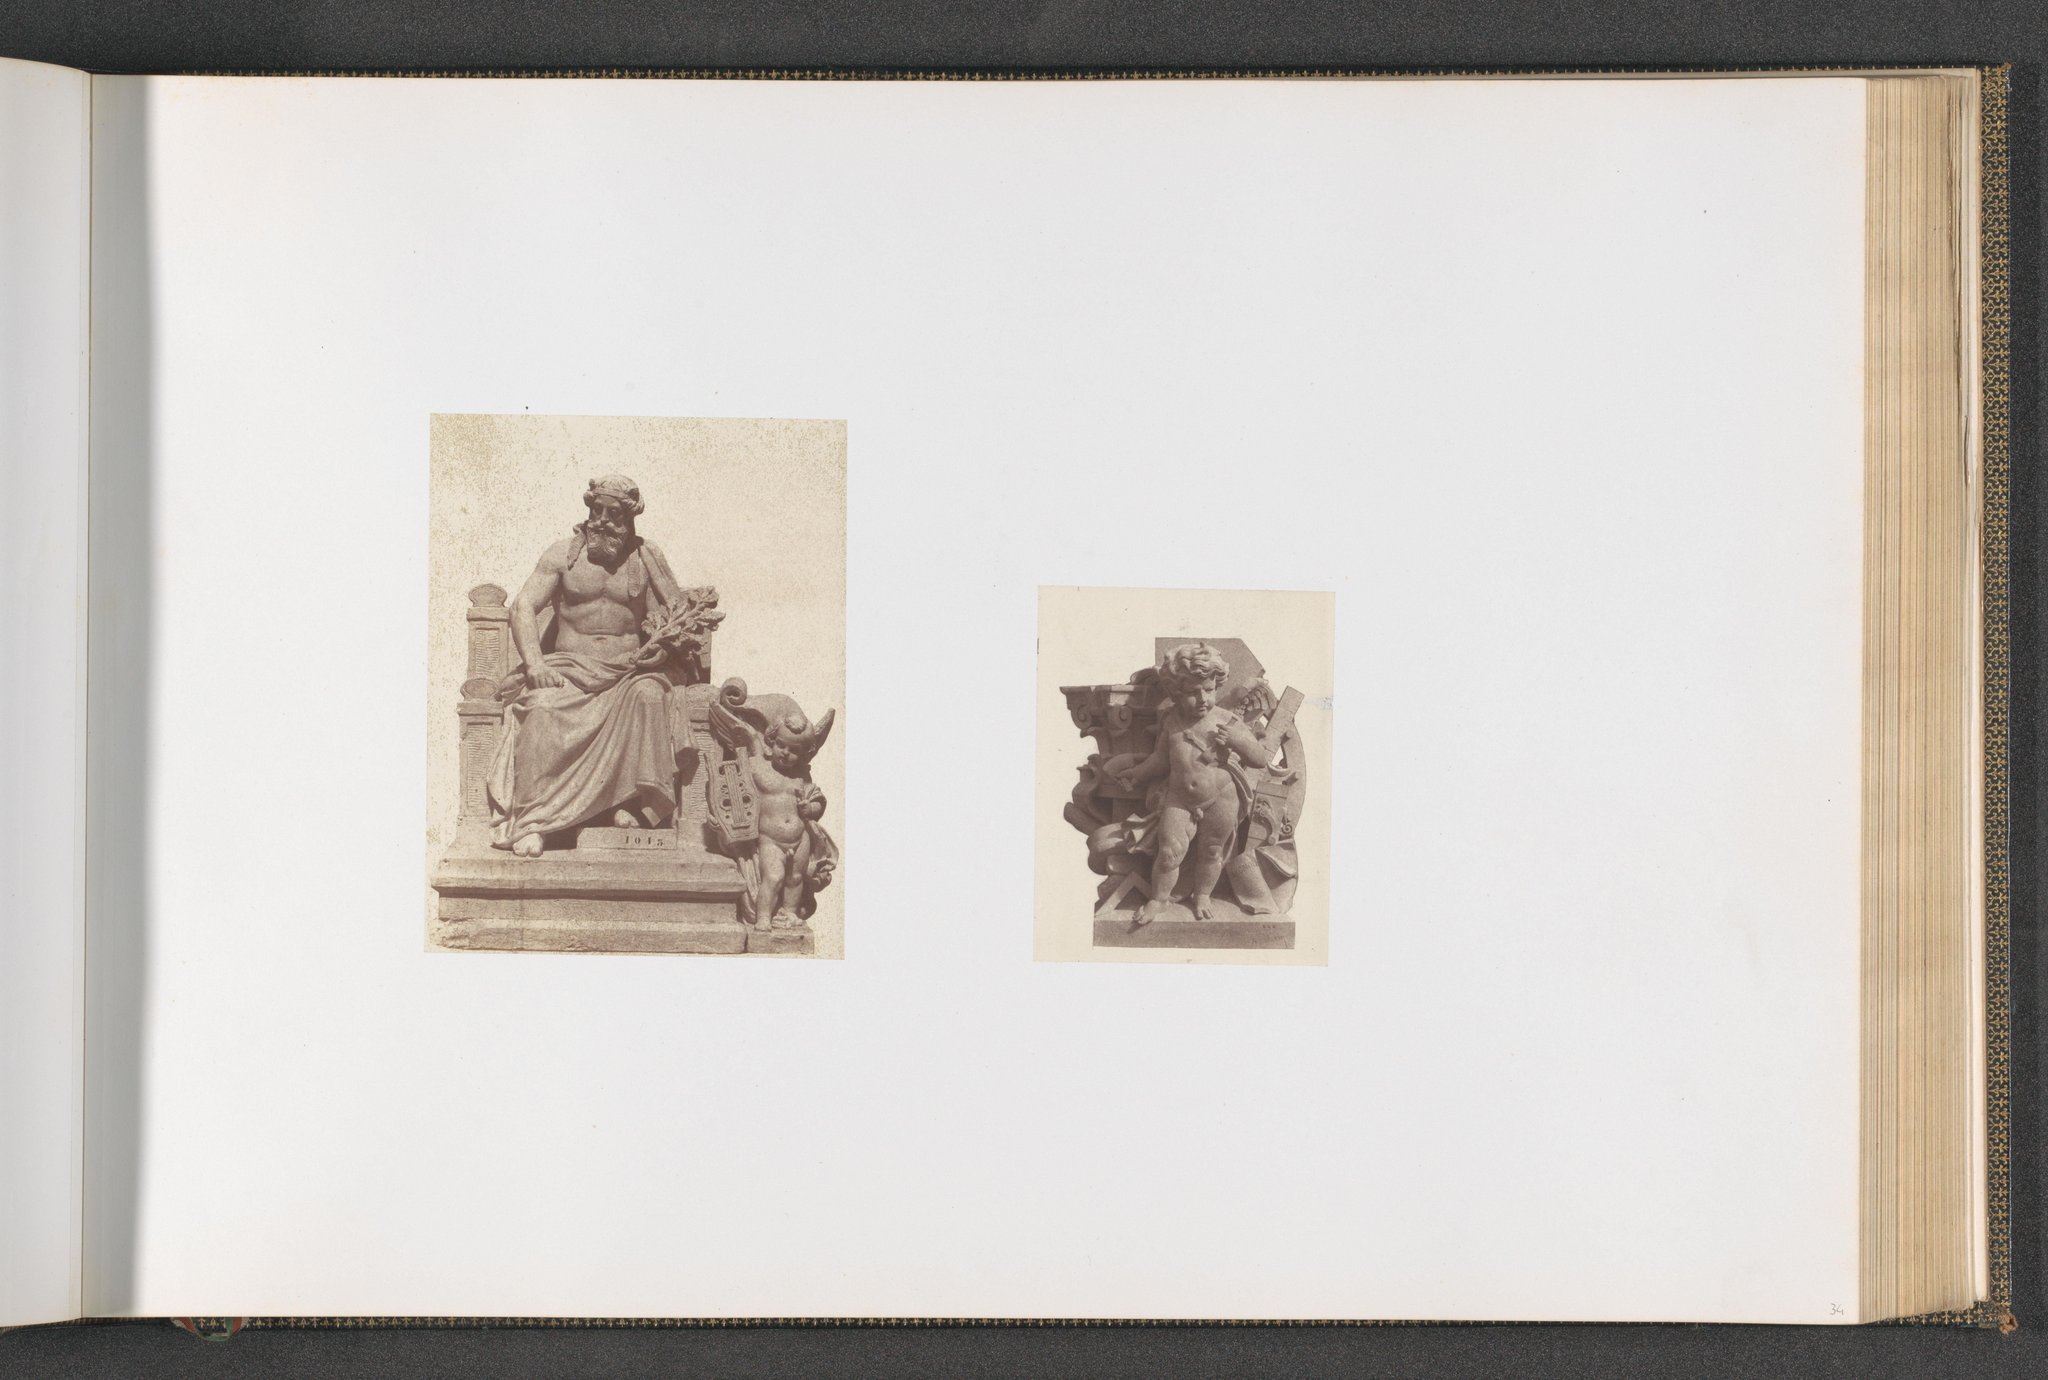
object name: album leaf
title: Gipsmodellen voor beeldhouwwerken op het Palais du Louvre: links "L'Art grec" door Gabriel Bernard Seurre en rechts "La Pierre" door Auguste Poitevin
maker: édouard denis baldus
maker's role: fotograaf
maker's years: 1813-1889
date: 1855-1857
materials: paper, photographic support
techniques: salted paper print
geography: paris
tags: piece of sculpture, reproduction of a piece of sculpture, permanent exhibition, museum, paris, tuileries palace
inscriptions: number: ‘1015 en 958’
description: Onderdeel van Réunion des Tuileries au Louvre 1852-1857, album 2.